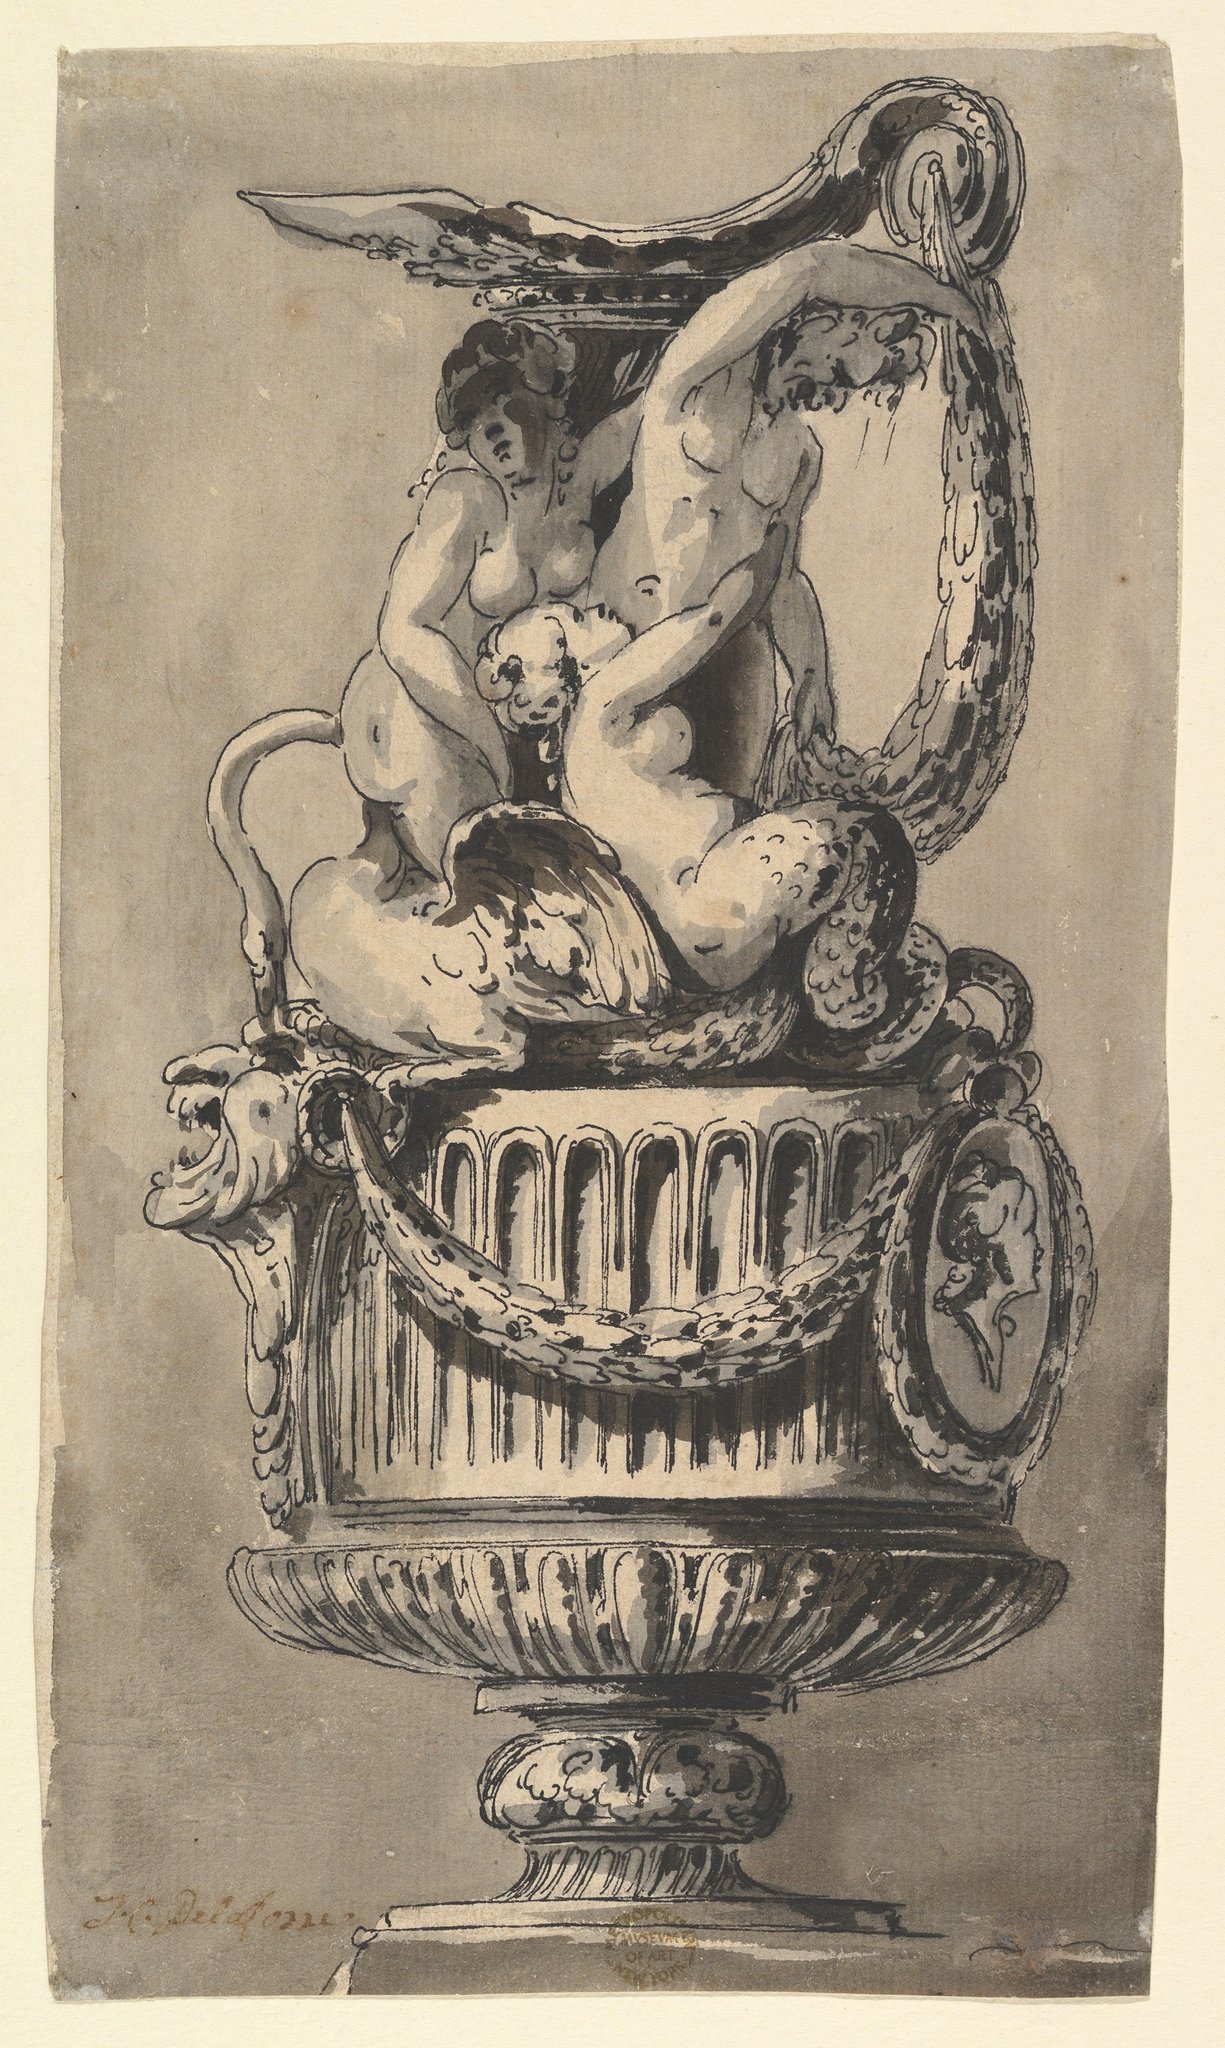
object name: drawing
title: Design for a Ewer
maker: jean charles delafosse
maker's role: artist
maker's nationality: french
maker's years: 1734-1789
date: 1734-1791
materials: ink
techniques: brush, pen, wash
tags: female nudes,ewers